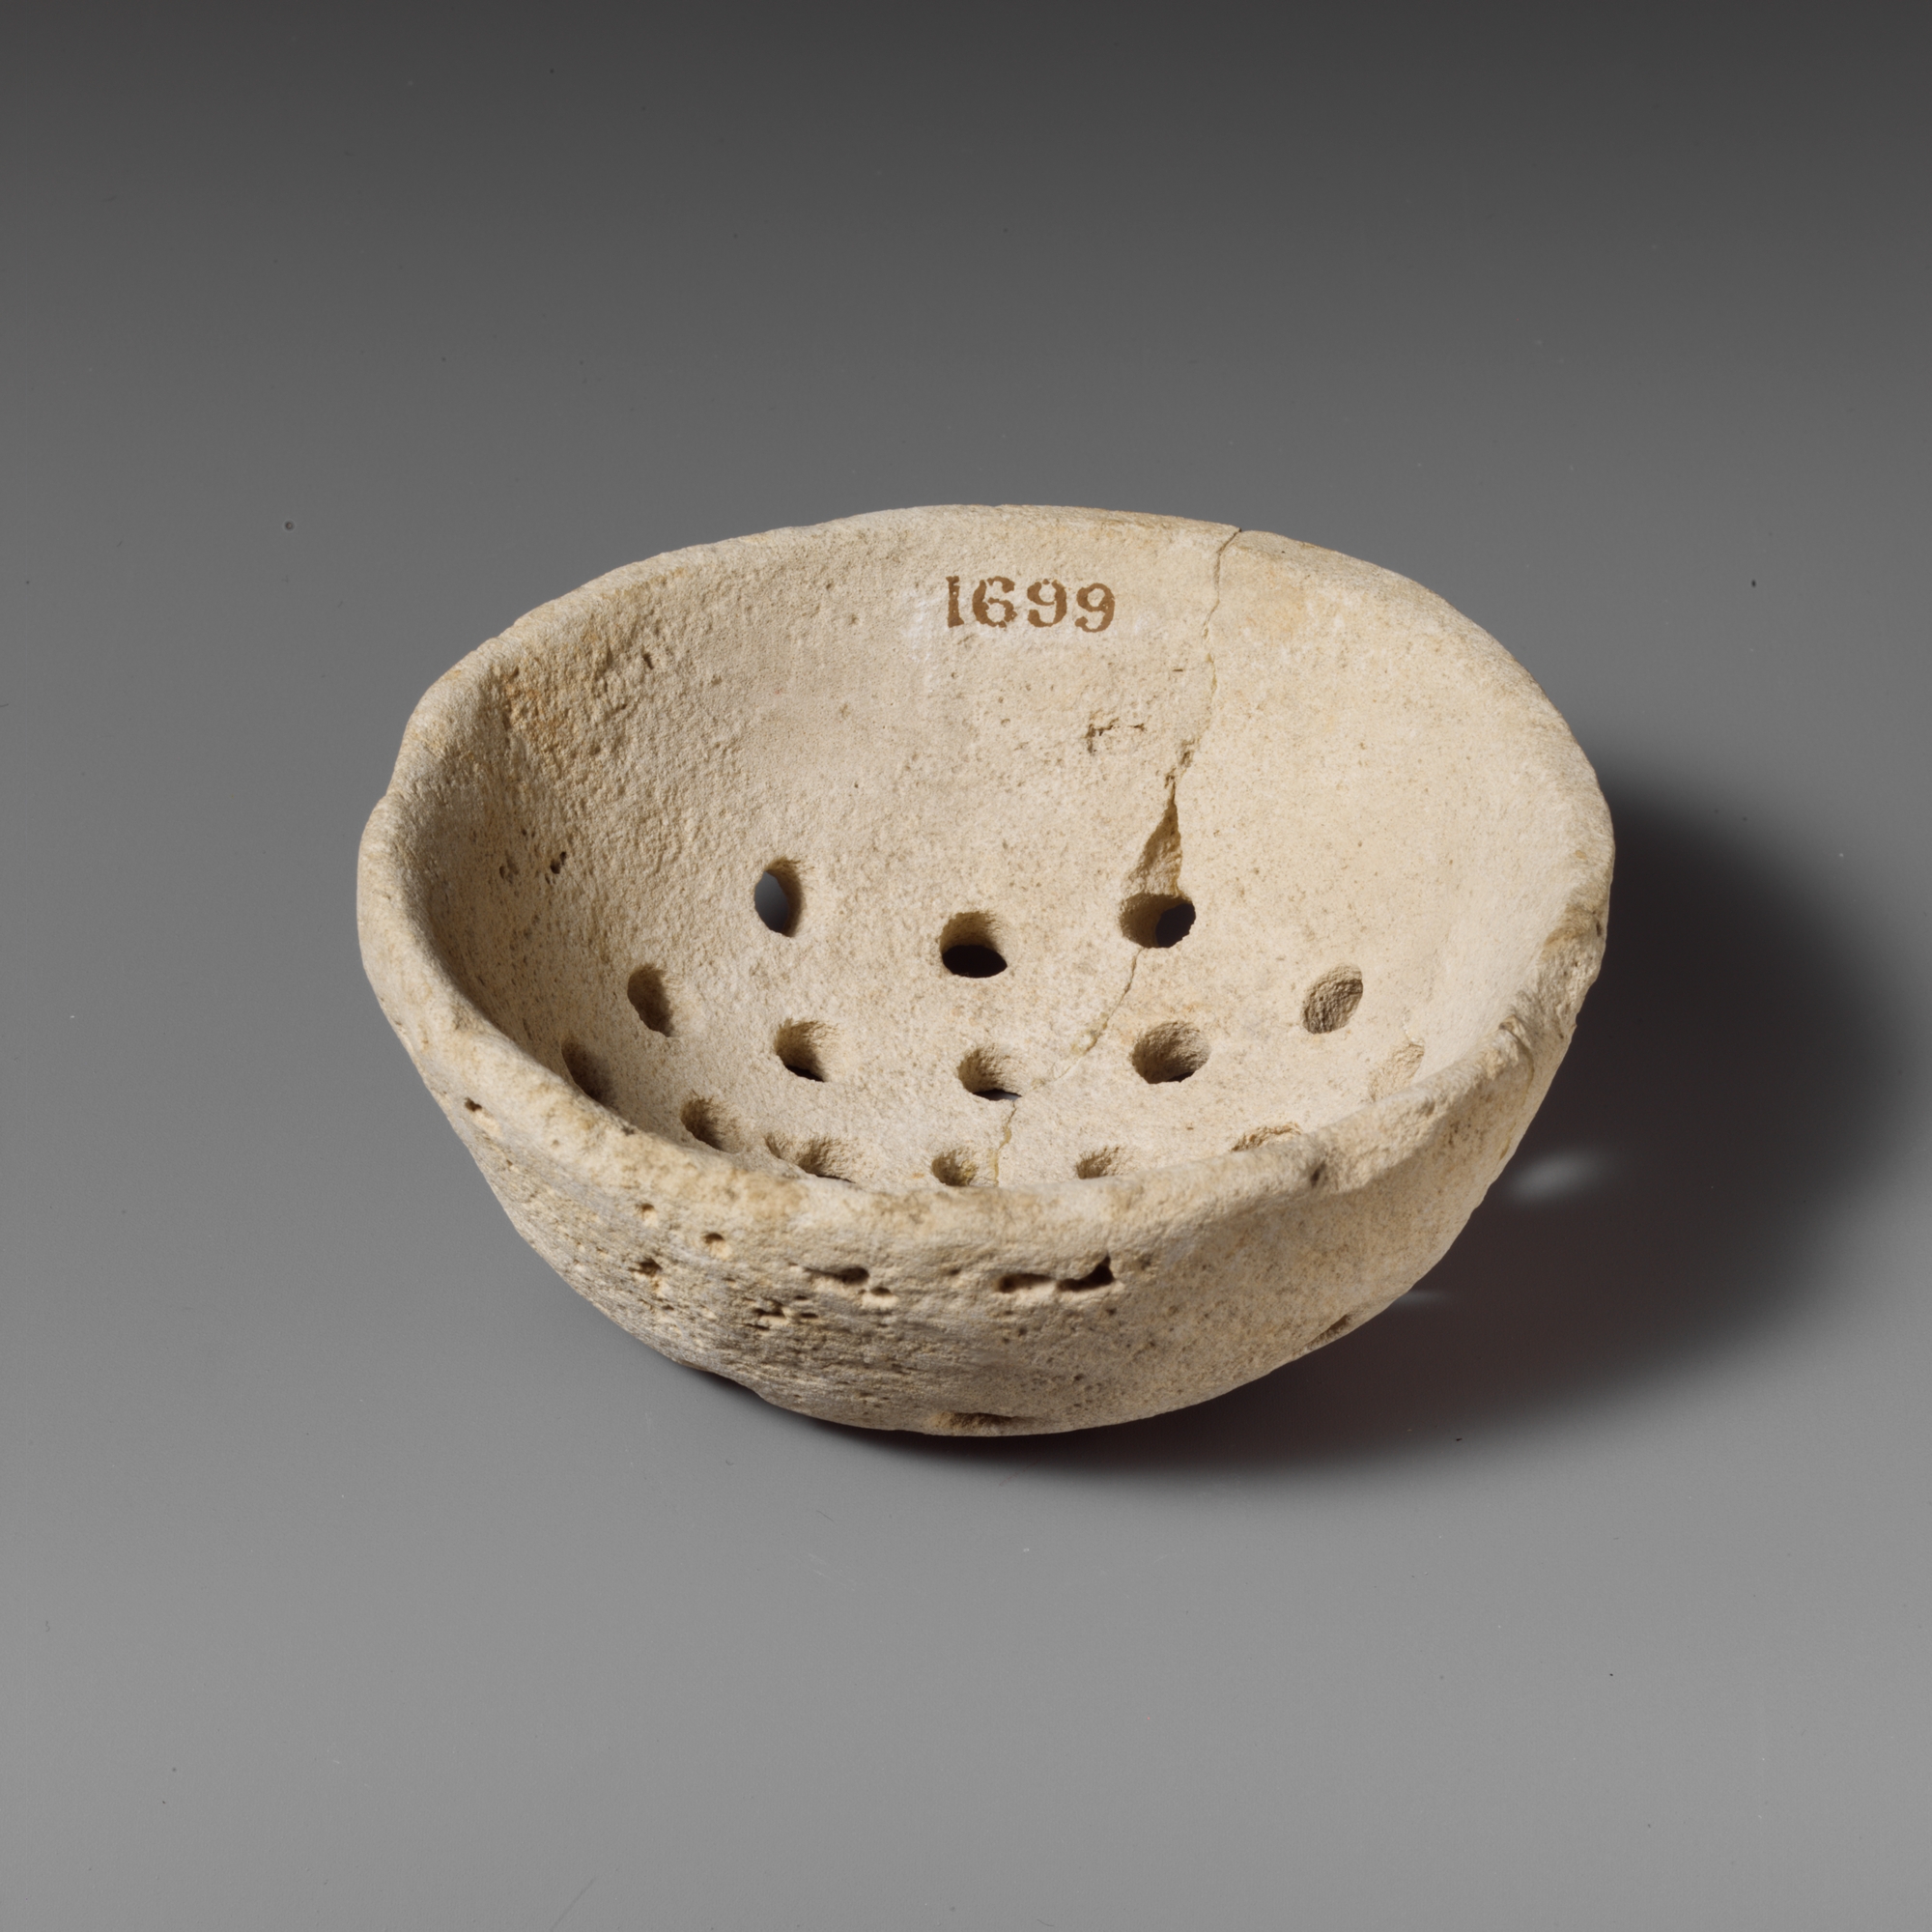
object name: strainer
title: Limestone strainer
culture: cypriot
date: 3900 BCE-100 CE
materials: limestone